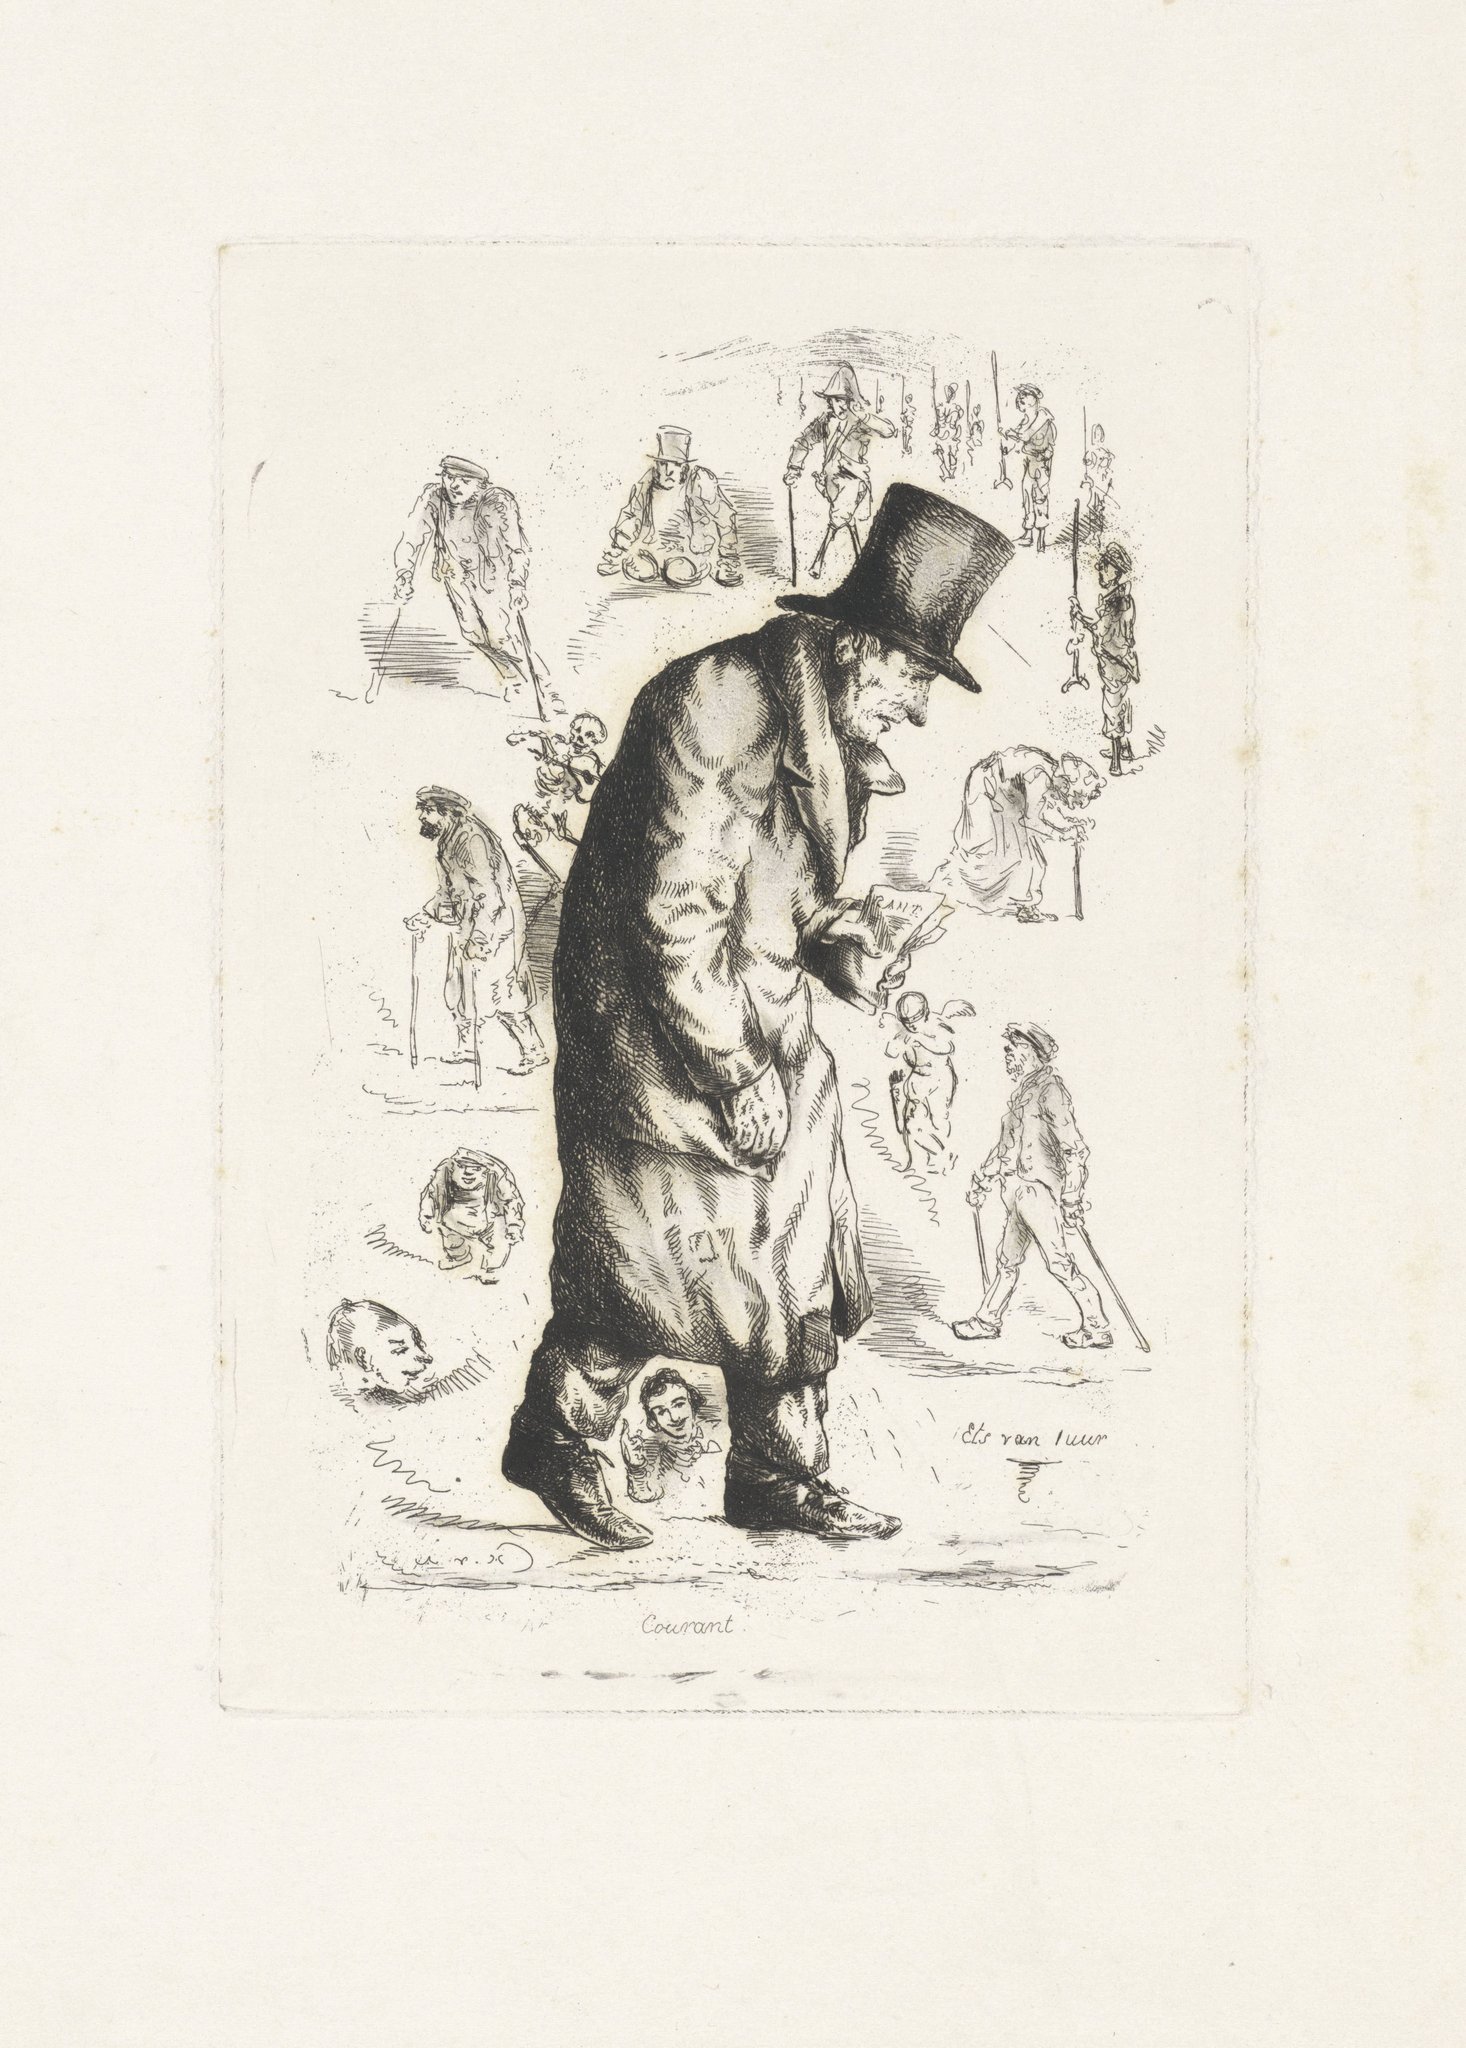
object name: print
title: Man met hoge hoed tegen en schetsen van mensen met verschillende lichamelijke beperkingen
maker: alexander ver huell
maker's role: draughtsman, print maker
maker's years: 1822-1897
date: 1832-1897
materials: paper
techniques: etching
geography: netherlands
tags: crutches, wooden leg, head-gear: hat (+ men's clothes), newspaper, news-sheet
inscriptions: inscription: ‘Ets van 1 uur’, collector's mark: Lugt 2228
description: Een man met een versleten jas aan en een hoge hoed op het hoofd heeft een krant in zijn hand en loopt licht gebogen naar rechts. Op de achtergrond verschillende figuren op krukken en soldaten met houten benen. Tussen deze figuren ook de Dood spelend op een viool.